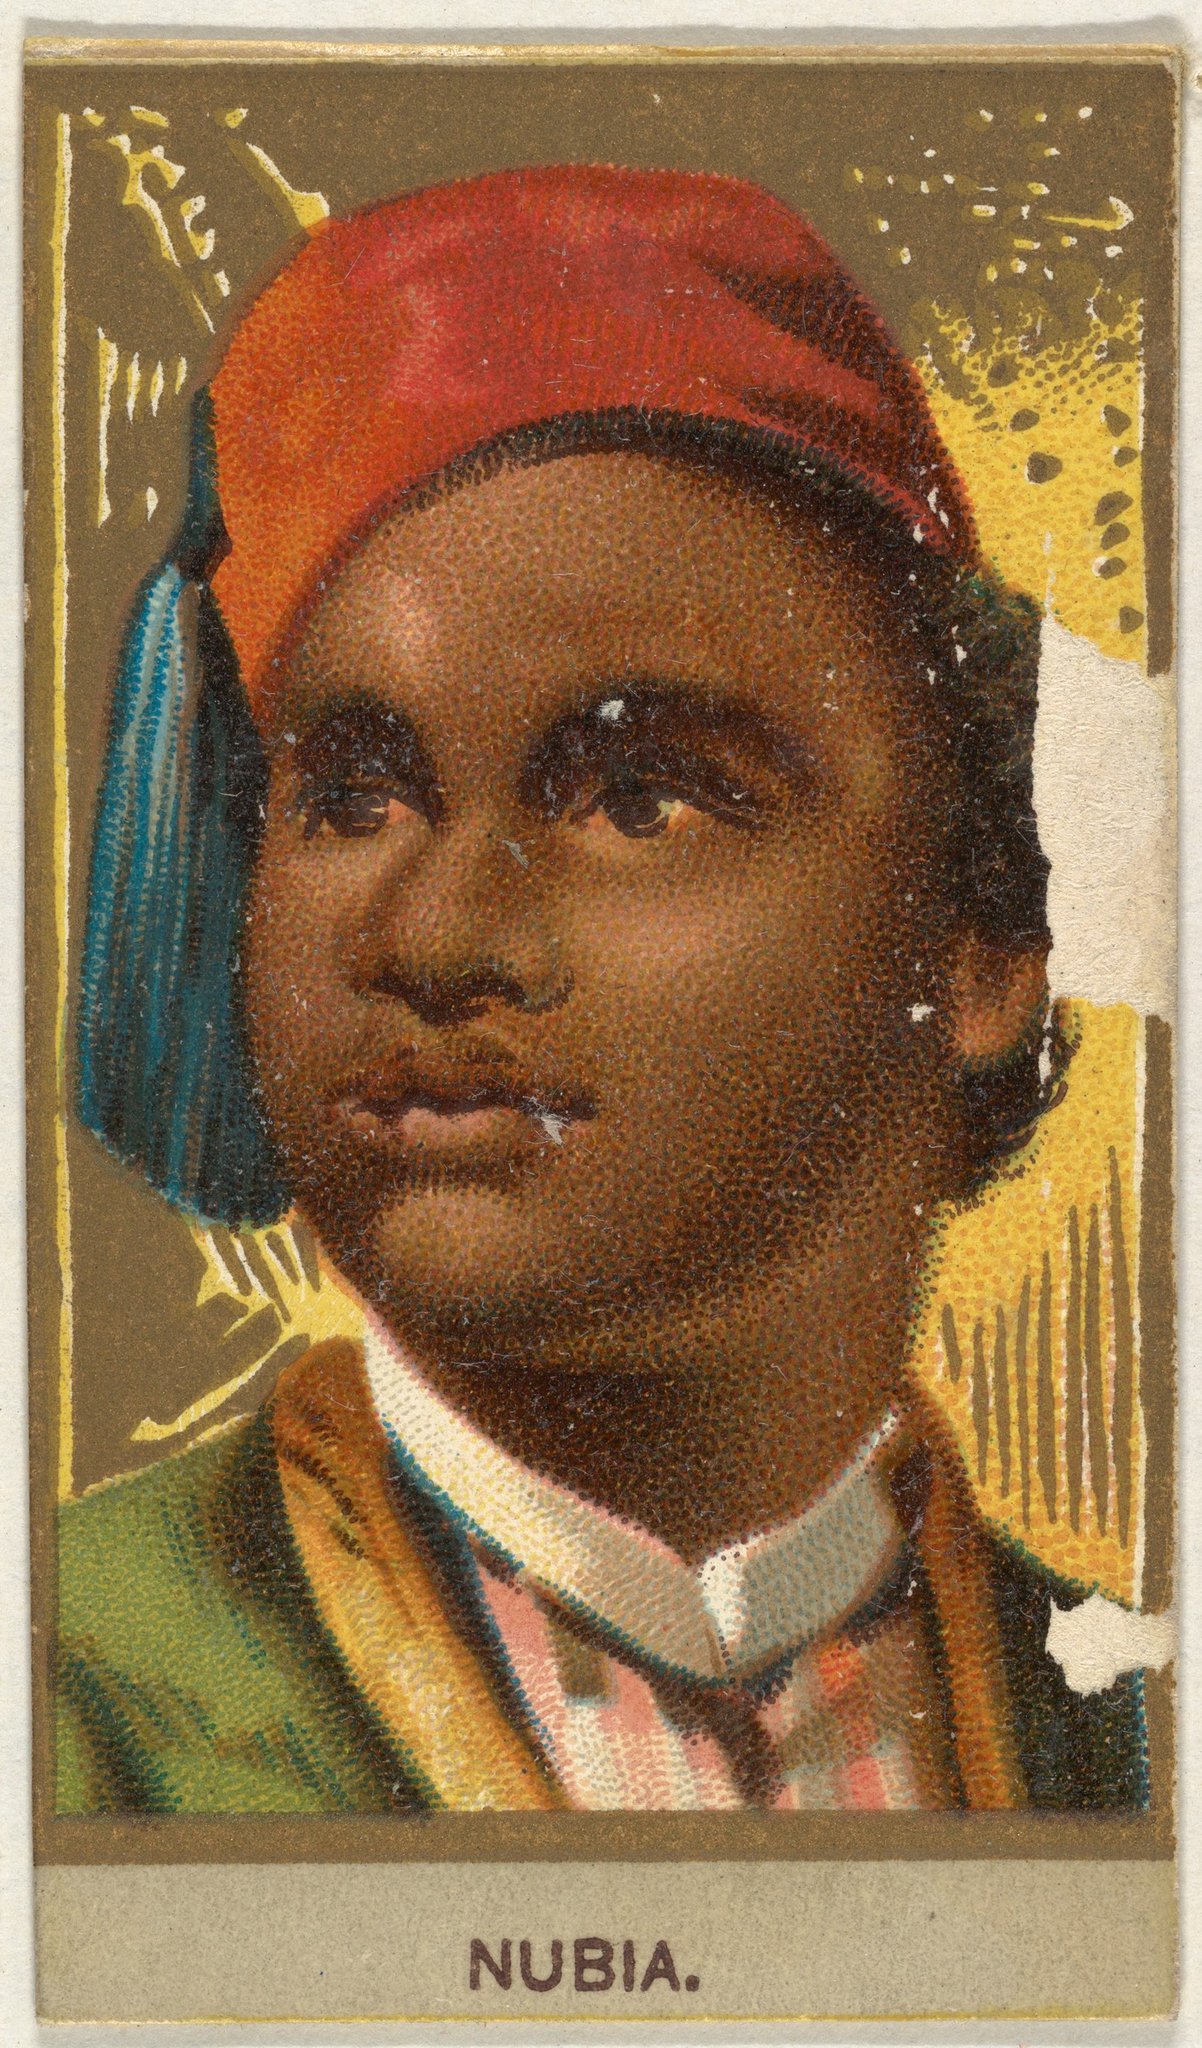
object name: print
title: Nubia, from the Races of Mankind series (T181) issued by Abdul Cigarettes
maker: abdul cigarettes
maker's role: publisher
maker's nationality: american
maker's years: 1881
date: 1881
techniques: color lithograph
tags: men